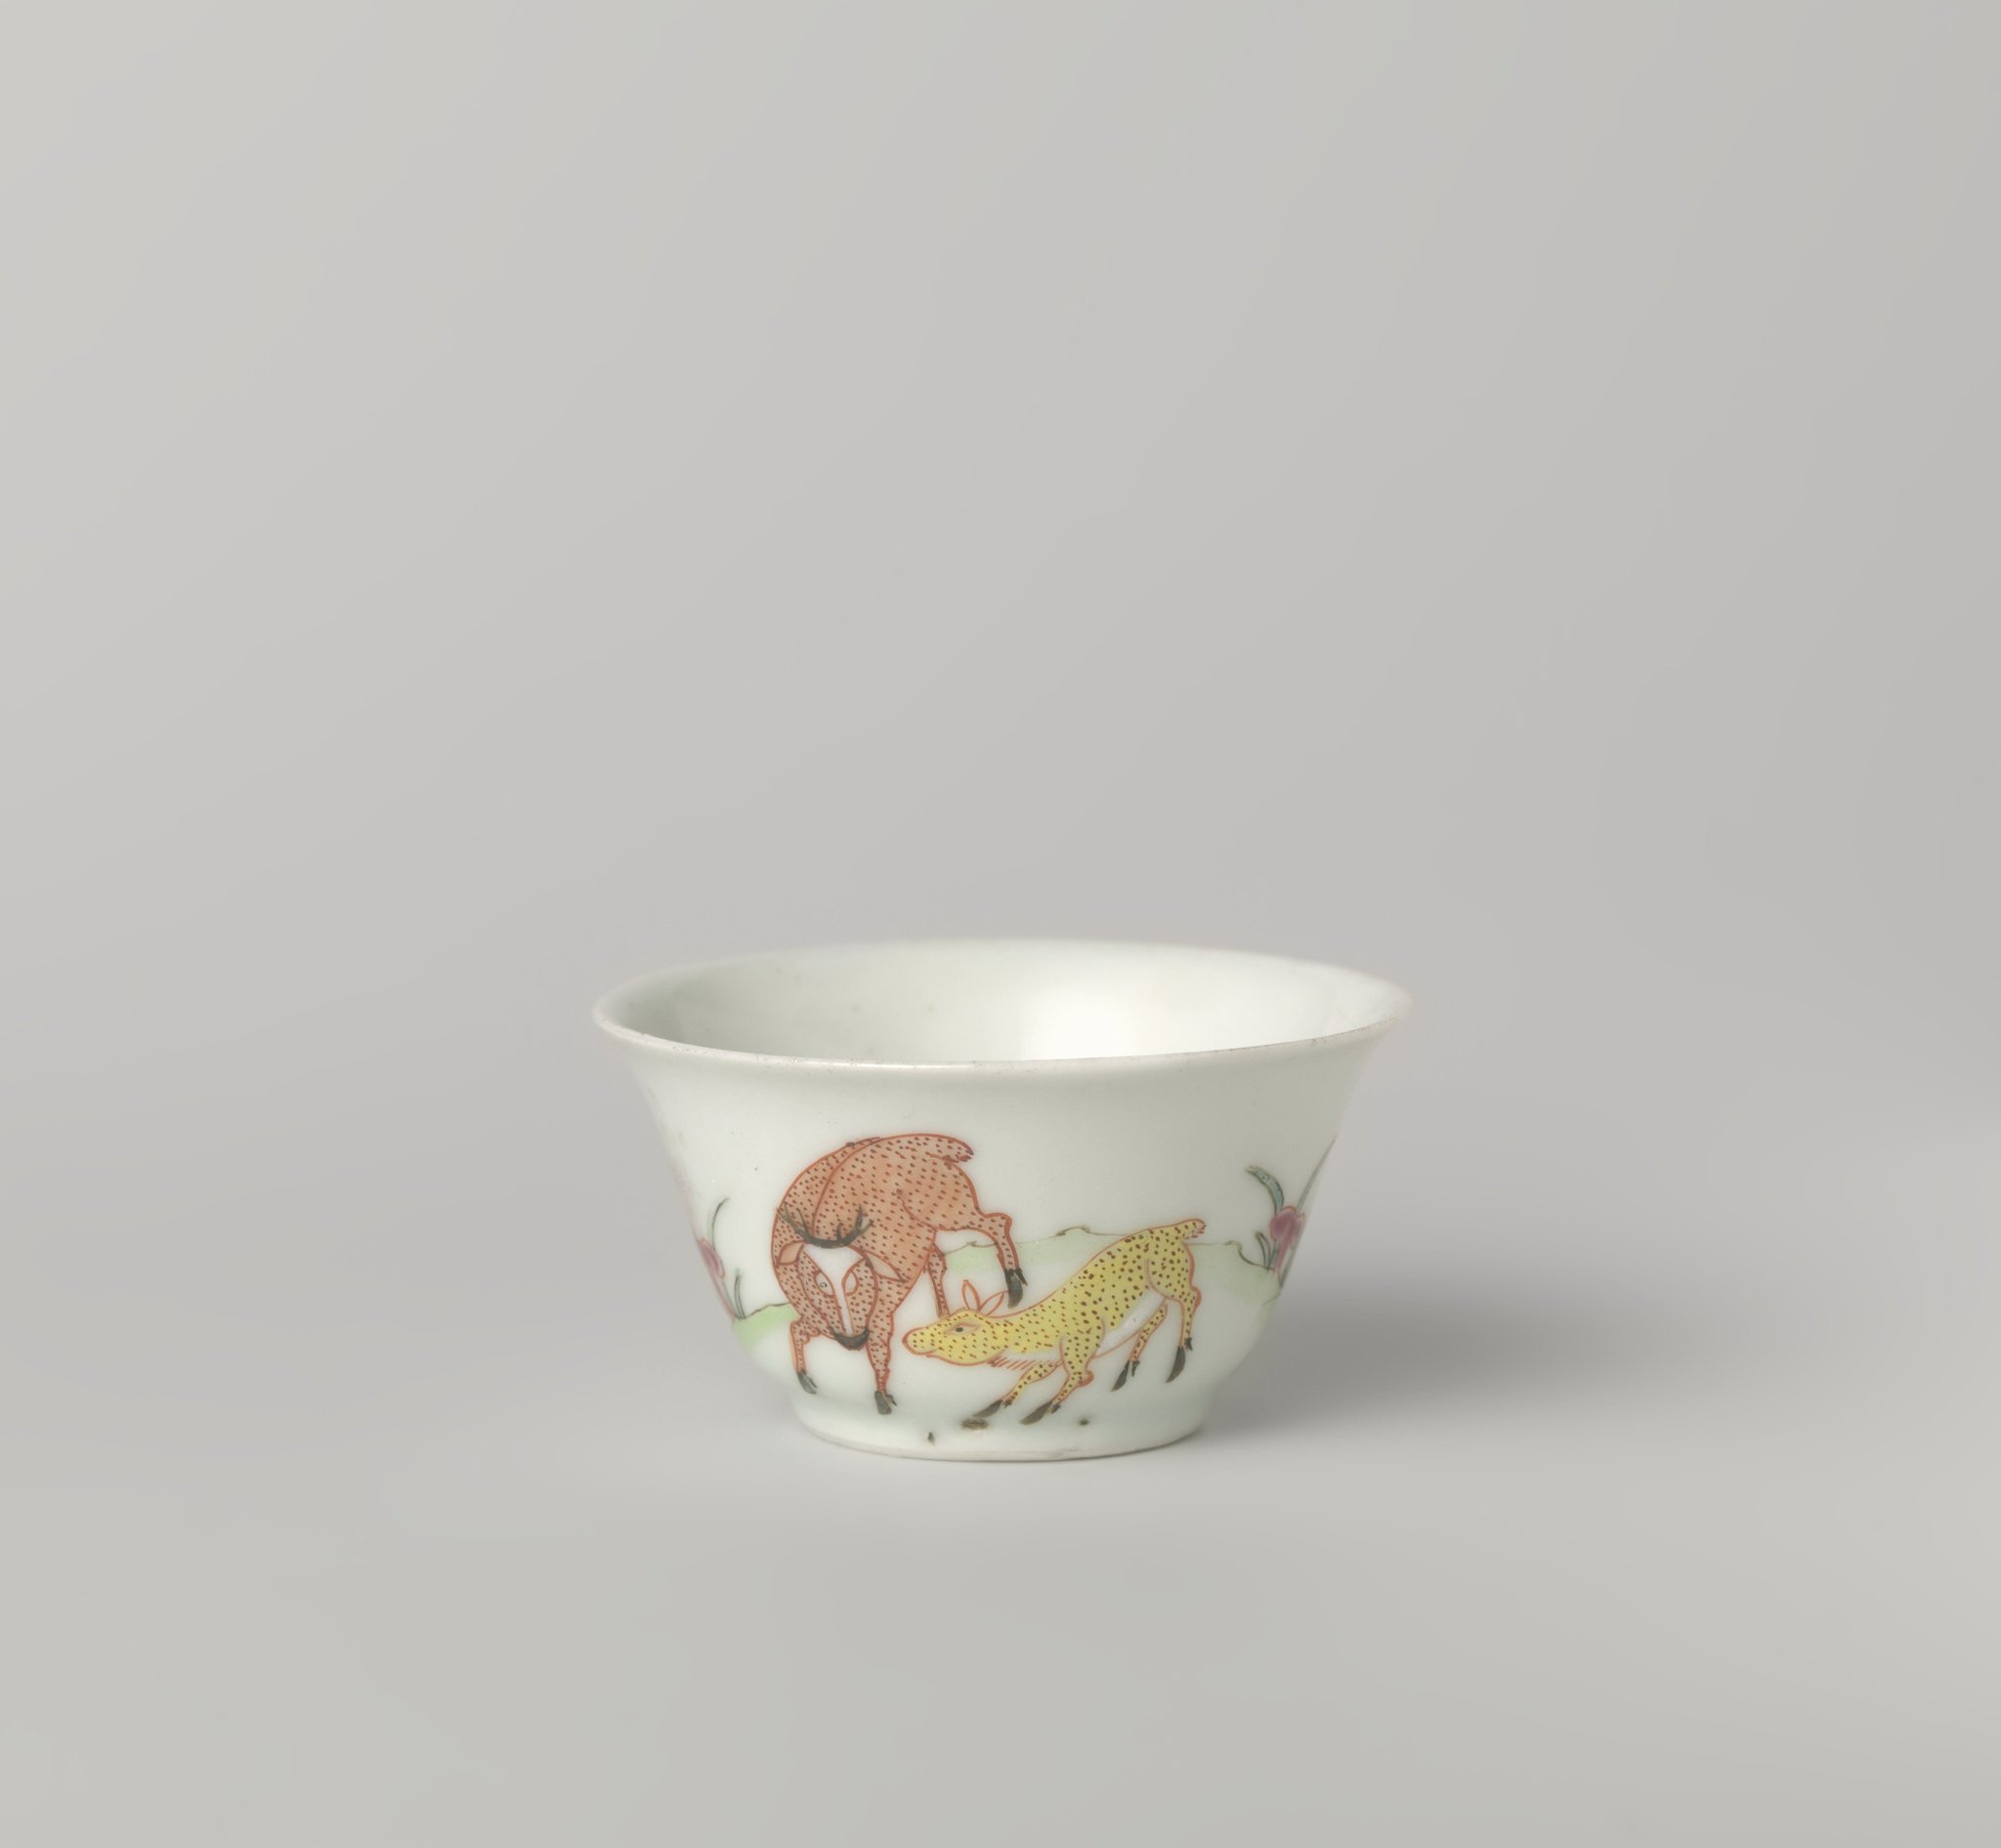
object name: cup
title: Bell-shaped cup with two deer in a landscape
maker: Anonymous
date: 1725-1749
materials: glaze, paint, porcelain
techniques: firing, turning, vitrification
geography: china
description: Klokvormige kop van porselein, beschilderd op het glazuur in blauw, rood, roze, groen, geel en zwart. Twee herten in een landschap met paddestoelen (lingzhi) en een vogel op een bloeiende prunus afgebeeld. Een barst in de rand. Famille rose.